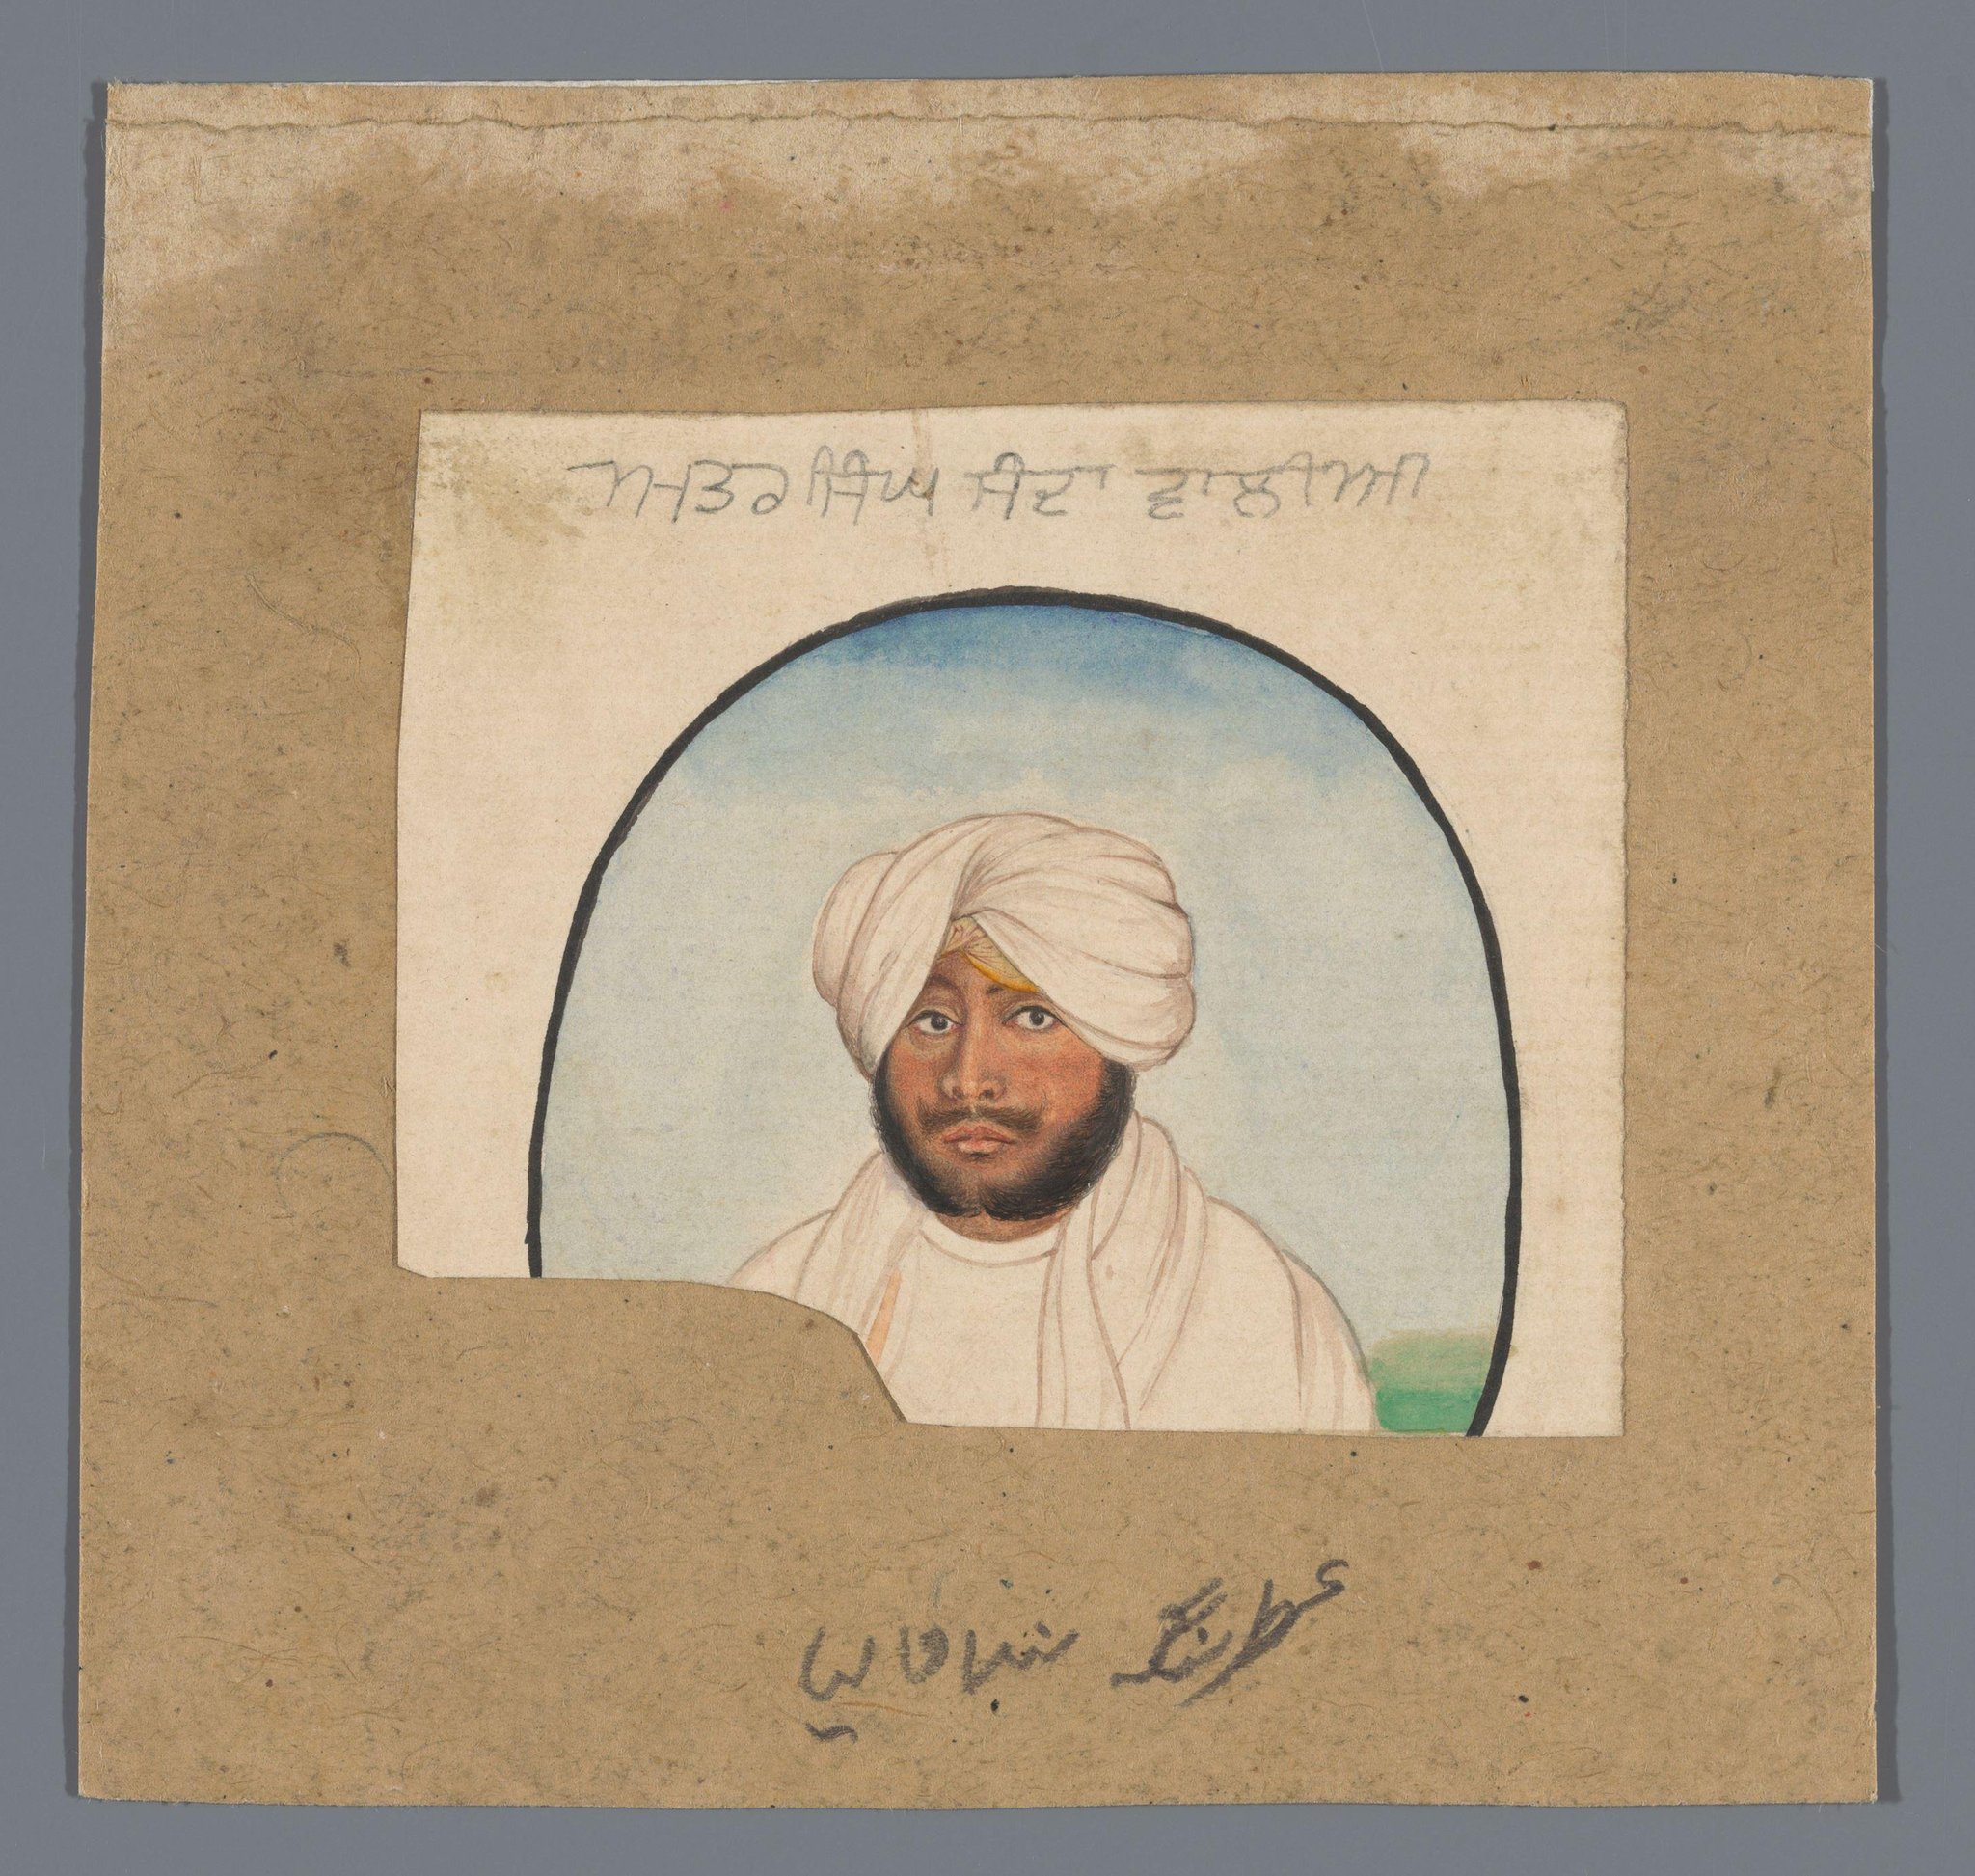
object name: indian miniature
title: Portret van Atar Singh Sandhanvalia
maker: Anonymous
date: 1860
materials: paper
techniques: brush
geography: punjab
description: Fragment van een portret (onderkant afgescheurd). Portret van een man in een witte tulband en een witte sjaal, in een ovaal met zwarte rand. Boven tekst in het Gurmukhi schrift: aa.tar si.mgh sedaa haaliiaa, onderaan in het Nashtaliq: a..tar singh s -- aa haaliyaa (i.e. Atar Singh Sandhanvalia).